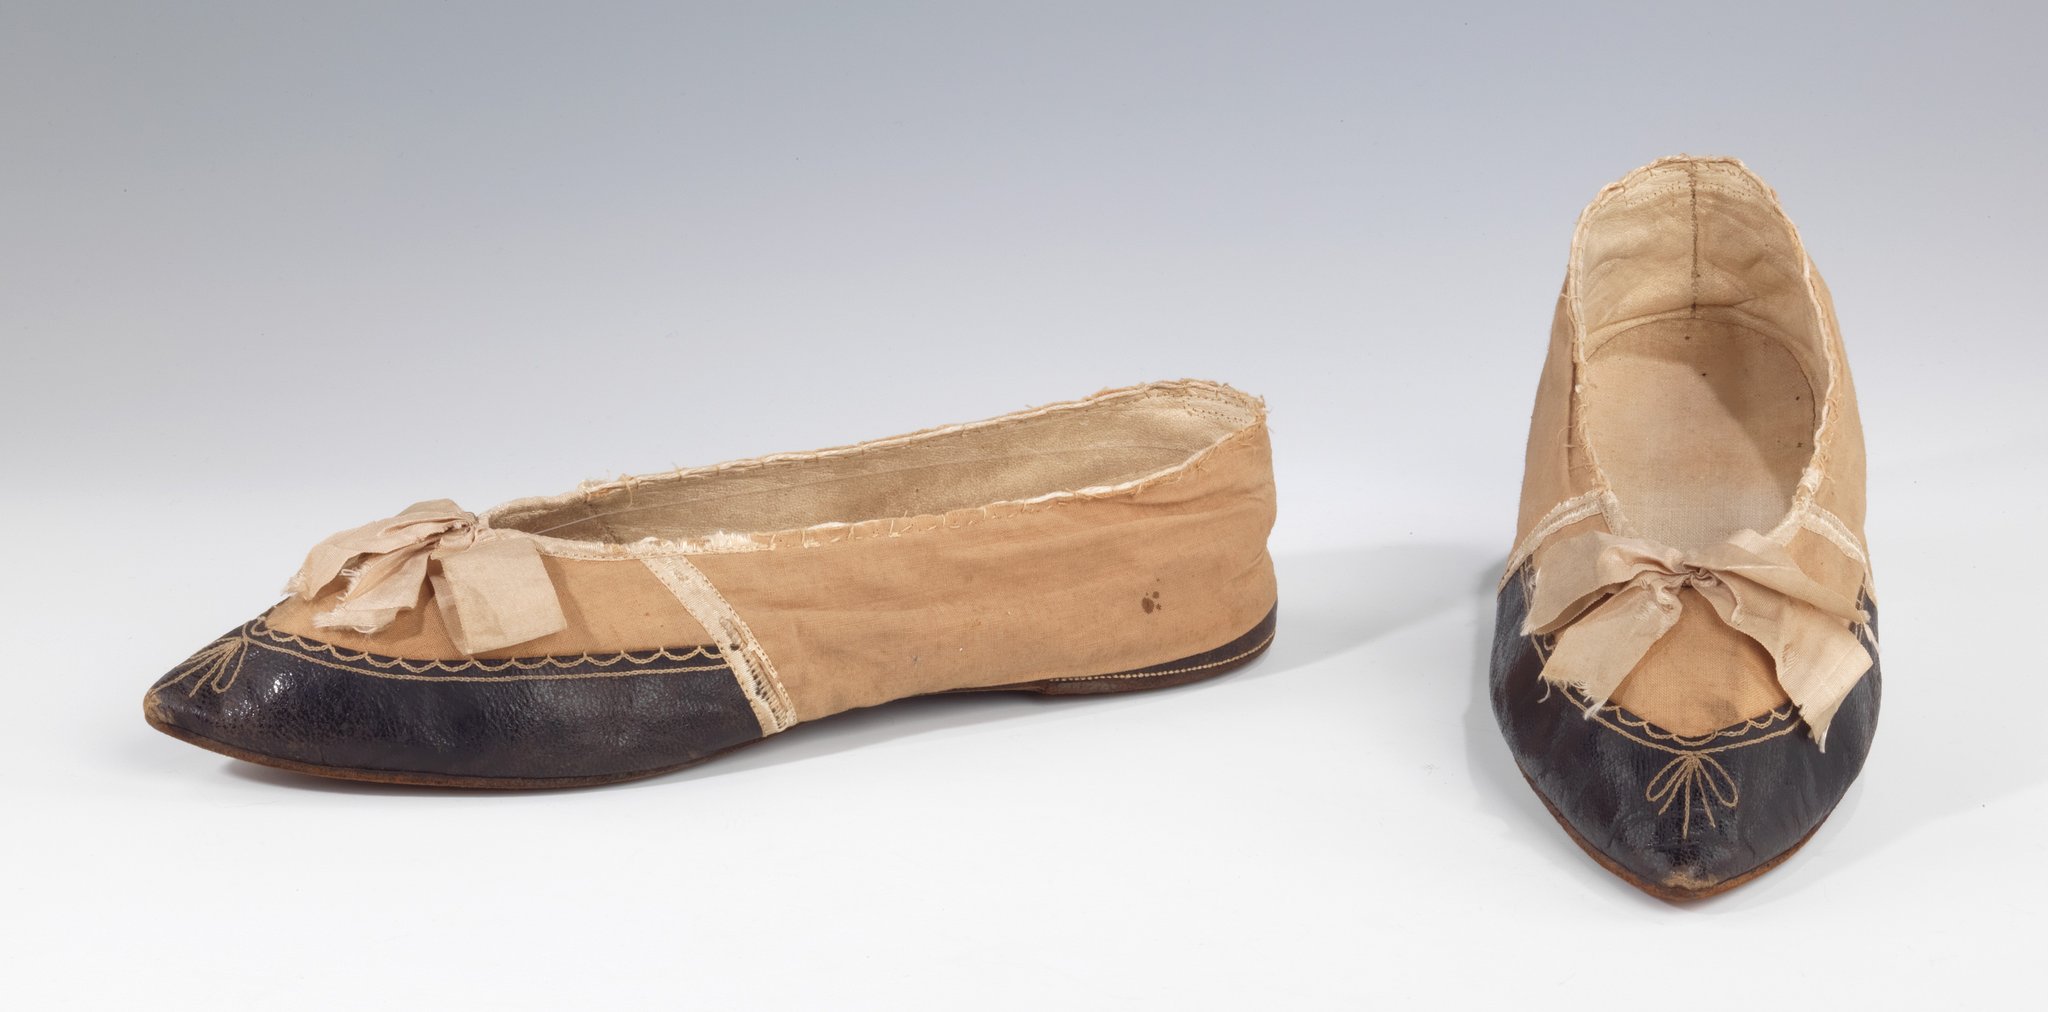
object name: slipper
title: Slippers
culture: british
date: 1812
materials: cotton, leather, silk